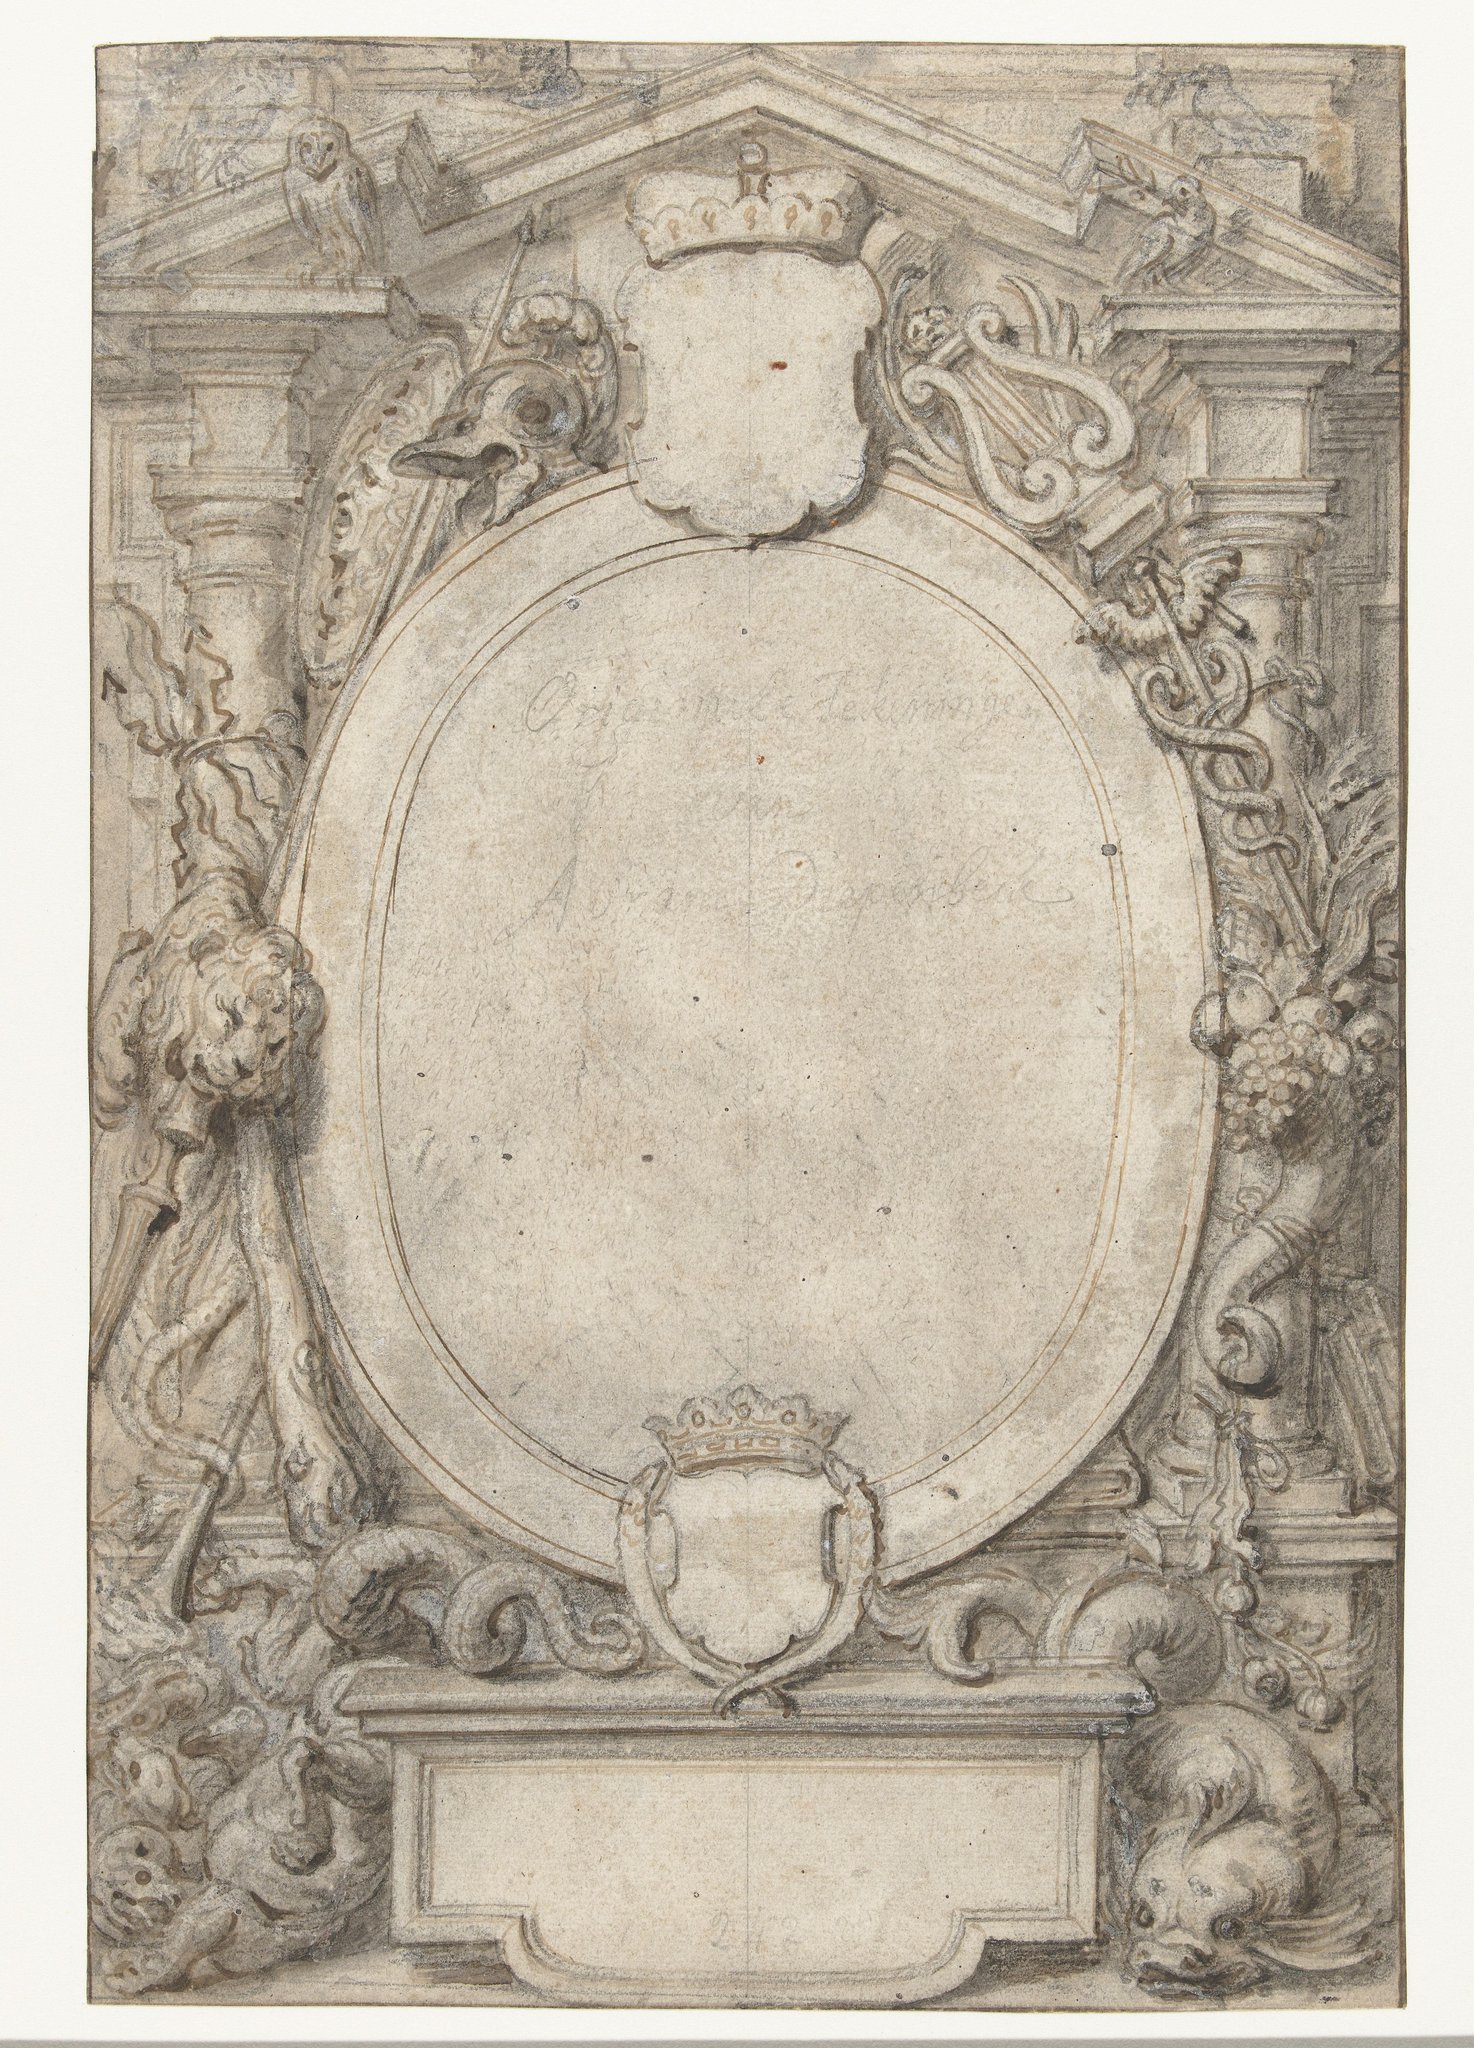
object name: design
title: Ontwerp voor een titelblad met twee lege wapenschilden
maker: abraham van diepenbeeck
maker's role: draughtsman, print maker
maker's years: 1596-1675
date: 1606-1675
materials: chalk, paint, ink, paper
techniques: brush, pen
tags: ornaments ~ art, attributes of mercury, attributes of mars